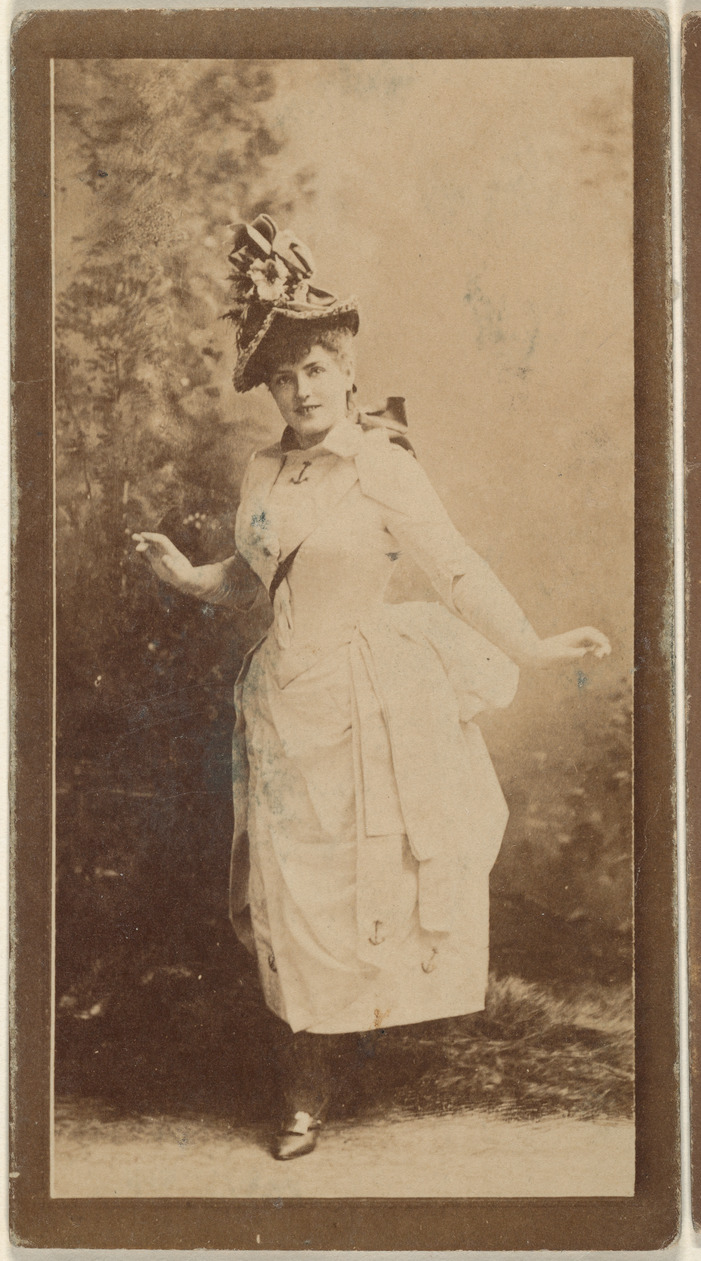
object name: photograph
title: Actress wearing elaborate floral hat, from the Actresses series (N668)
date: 1888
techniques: albumen silver print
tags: portraits,women,actresses